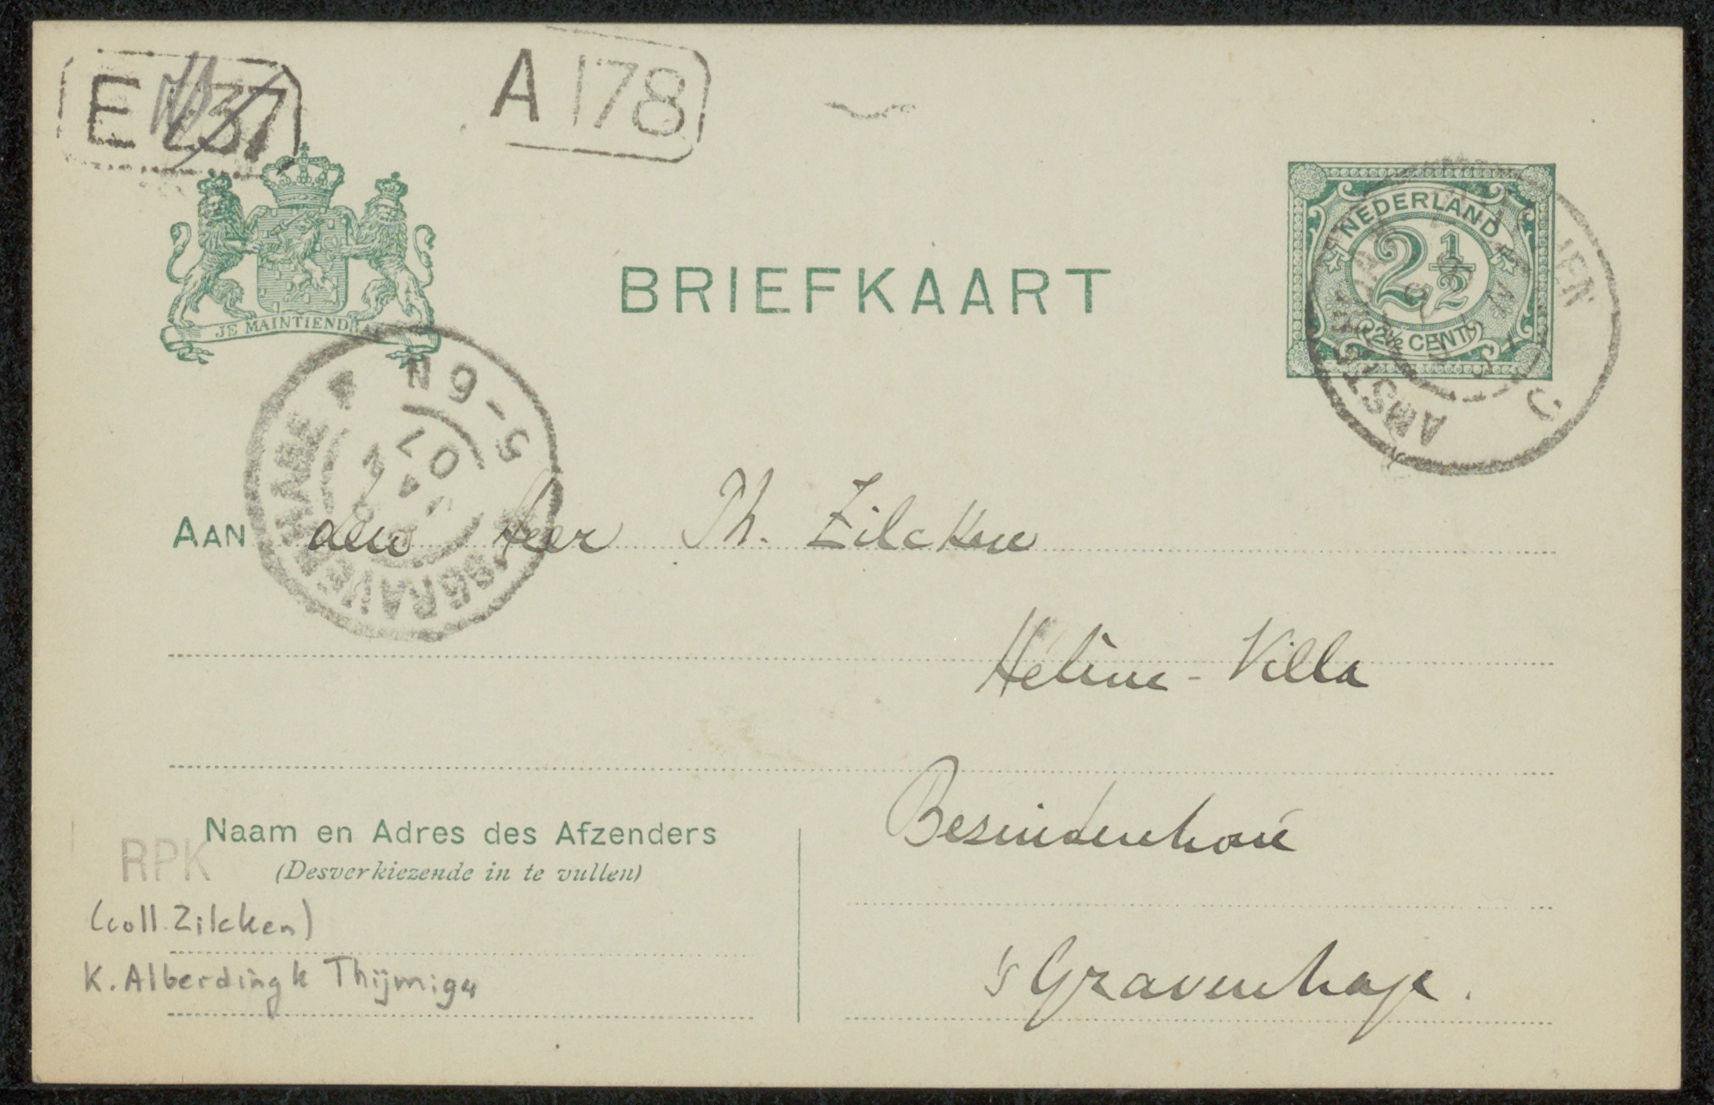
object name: postcard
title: Briefkaart aan Philip Zilcken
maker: karel johan lodewijk alberdingk thijm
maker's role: criticus, prozaschrijver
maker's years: 1864-1952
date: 1907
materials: cardboard, ink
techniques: pen, writing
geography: baarn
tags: painter, draughtsman, philip zilcken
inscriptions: collector's mark: ‘RPK’